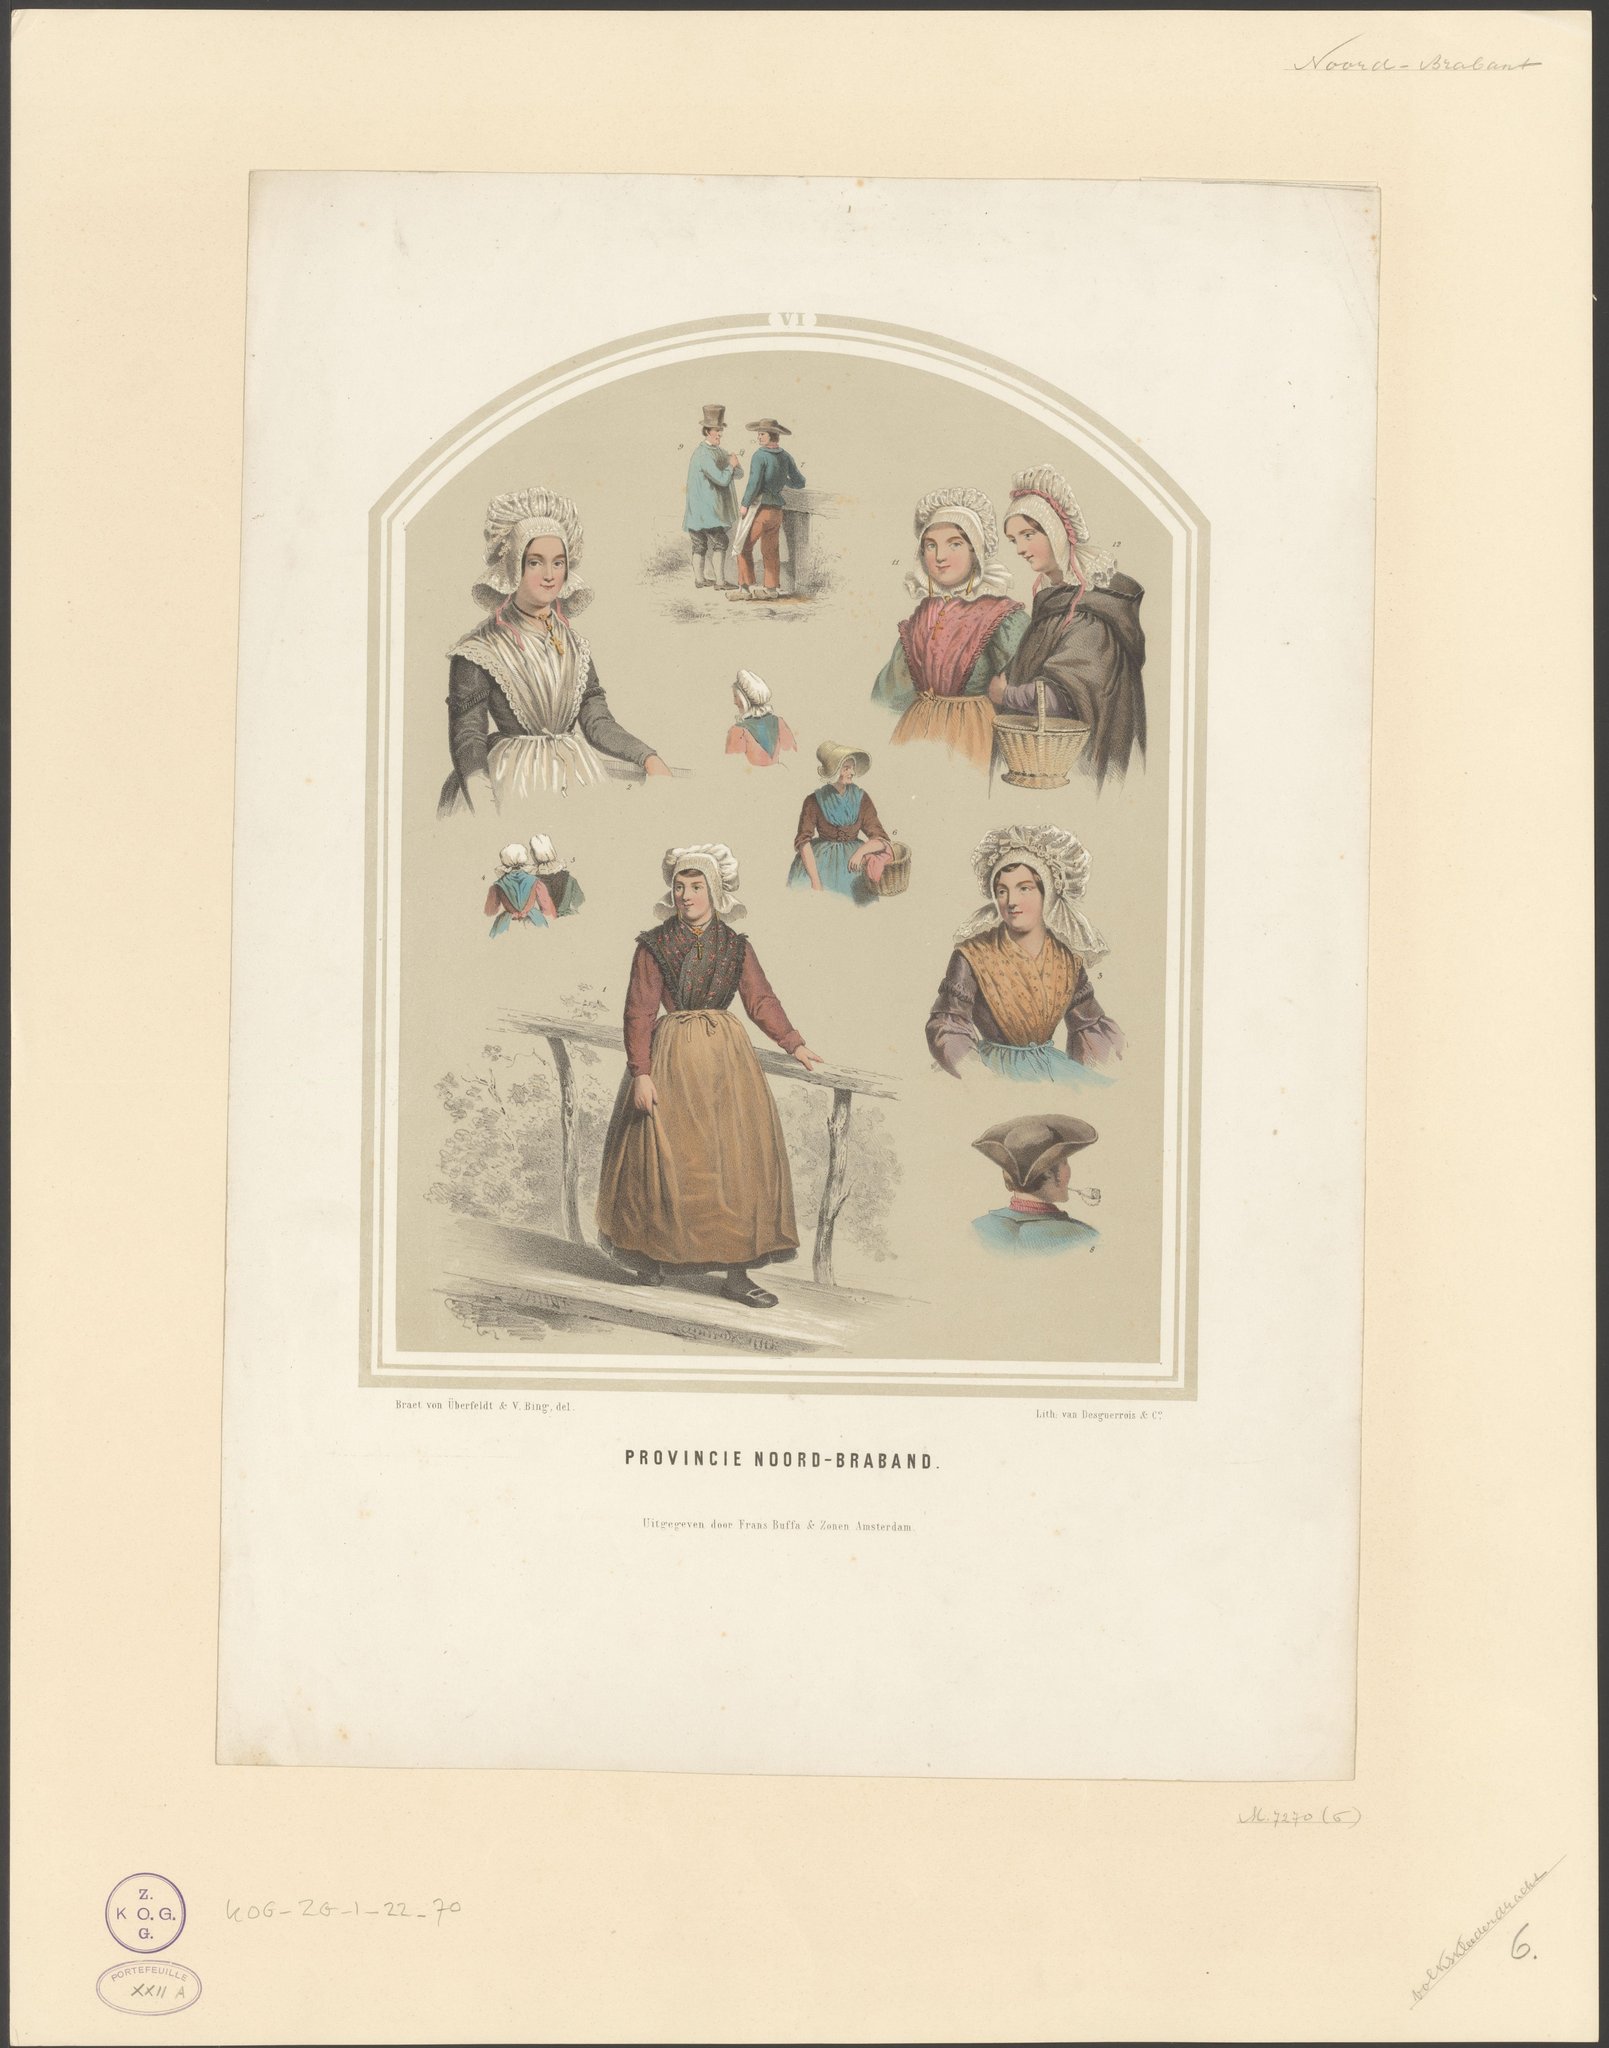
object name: print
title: Provincie Noord-Braband / VI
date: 1857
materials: paper, watercolor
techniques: hand coloring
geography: netherlands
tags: farmers, farmers - aa - female farmer, farmer's wife, clothes, costume (+ women's clothes), clothes, costume (+ men's clothes), folk costume, regional costume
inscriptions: collector's mark, collector's mark: Lugt 1641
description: Klederdracht van de provincie Noord-Brabant. Verschillende studies van mannen en vrouwen. Illustratie uit een boek uit 1857 met 56 platen van Nederlandse klederdrachten. Onderwerpsrubrieken binnen de Atlas Zeden en Gewoonten: De Kleeding, Volkskleederdracht, Noord-Brabant.